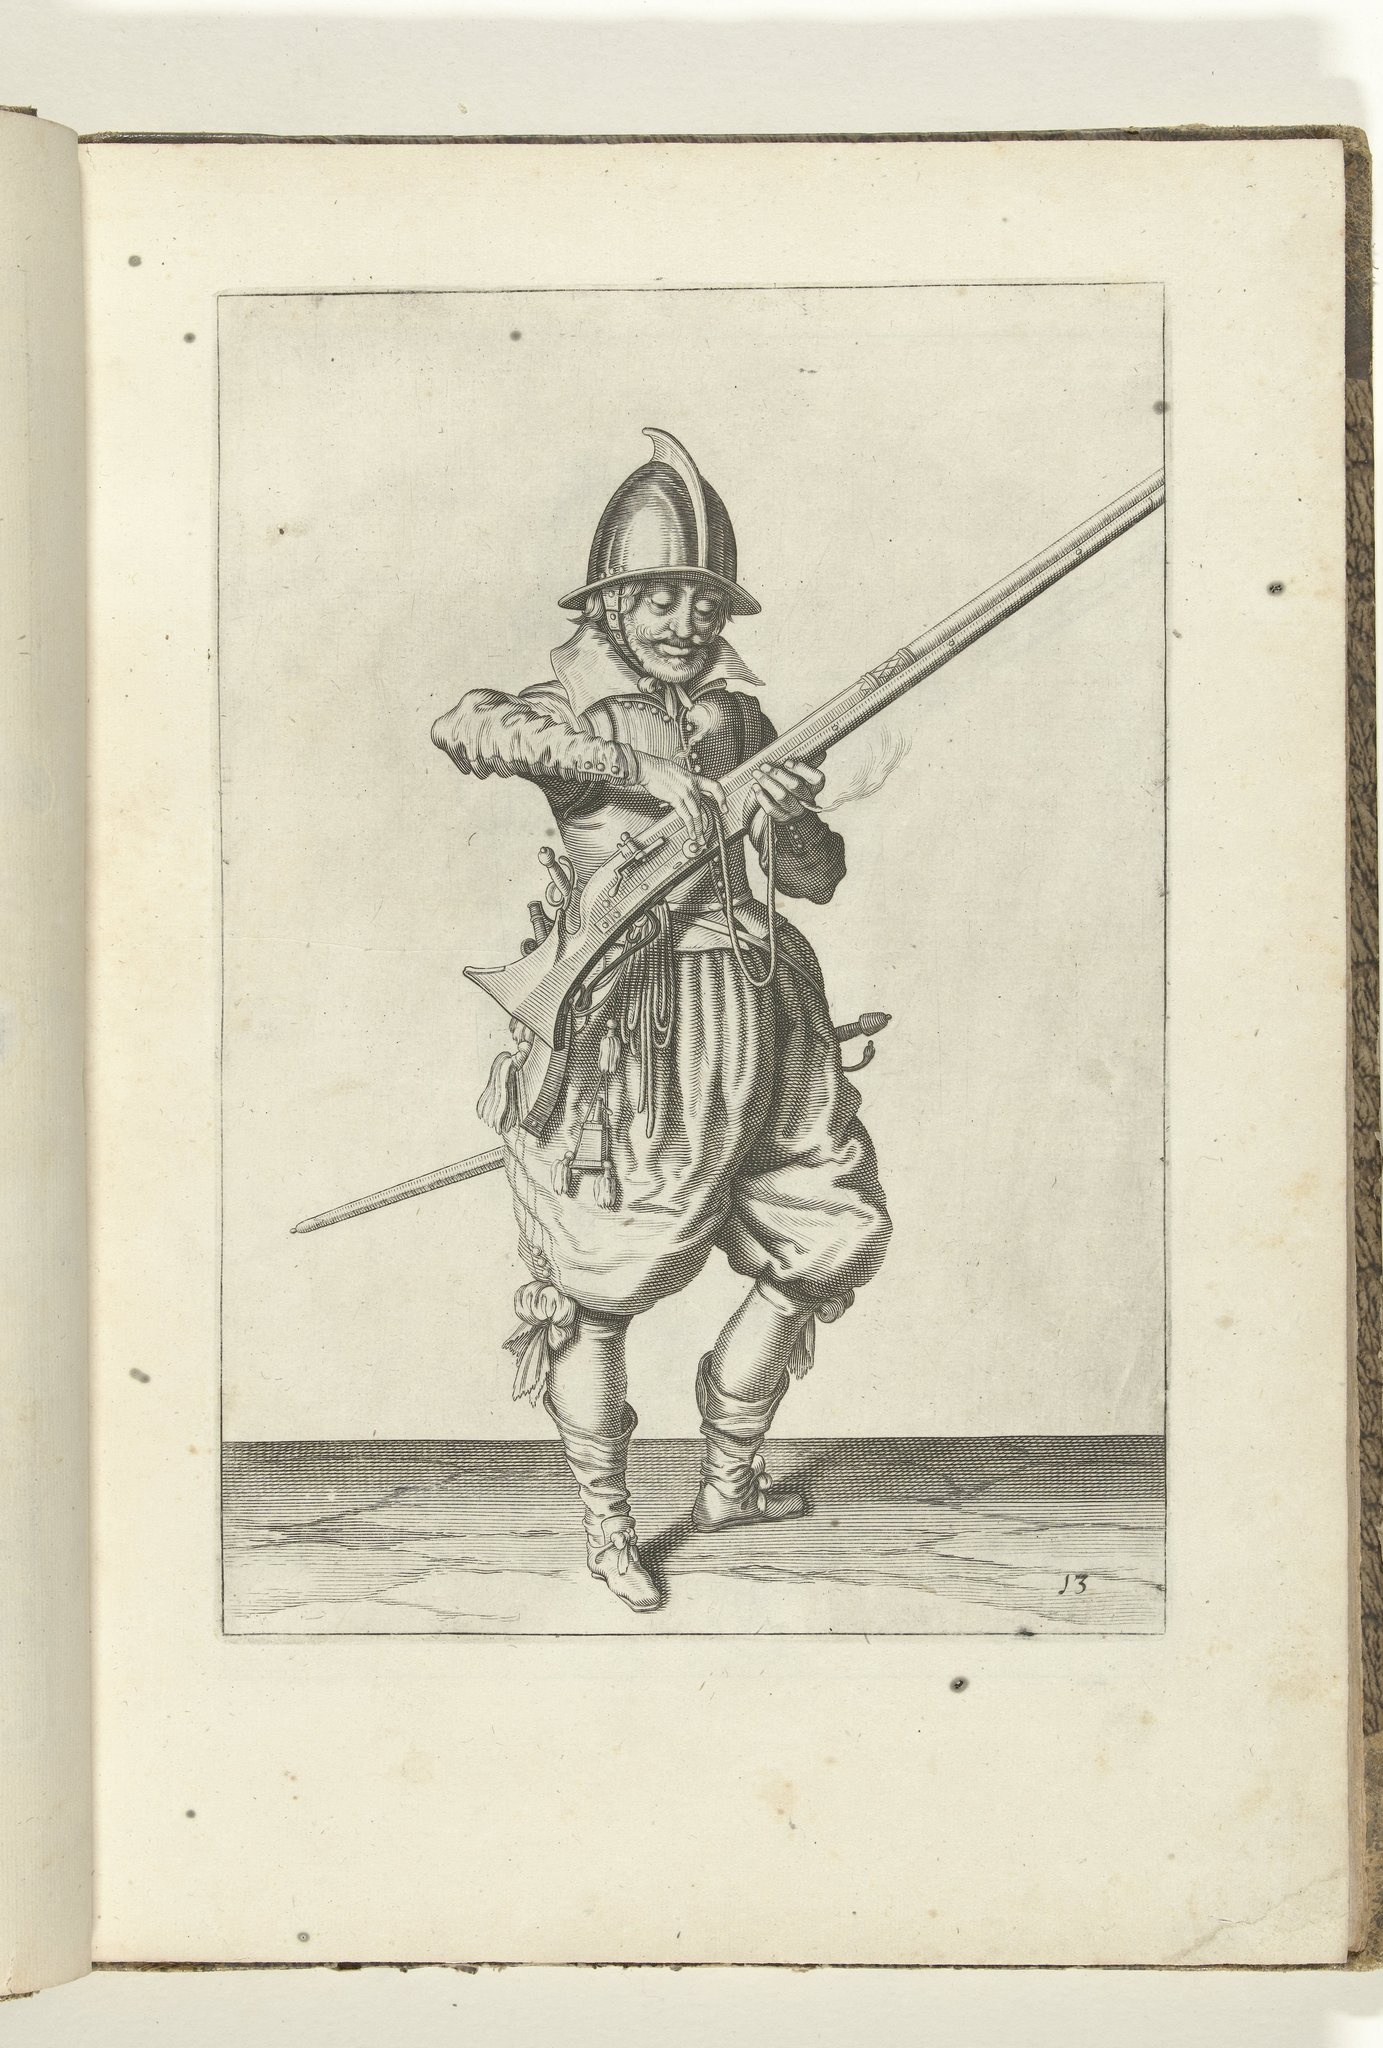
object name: print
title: Soldaat die zijn lont van de haan van zijn roer losmaakt (nr. 13), ca. 1600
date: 1597-1608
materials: paper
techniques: engraving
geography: northern netherlands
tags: the hague, maurice (prince of orange), handling of weapons ~ military training, weapons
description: Een soldaat, ten voeten uit, naar rechts, die een roer (een bepaald type vuurwapen) met zijn linkerhand vasthoudt (nr. 13), ca. 1600. Met zijn rechterhand maakt hij de brandende lont los die op de haan (onderdeel van het ontstekingsmechanisme) van zijn roer ligt. Plaat 13 in de instructies voor het hanteren van de roer: Brief enseignement, sur la representation des figures, du droit maniement de l'Harquebuse. Onderdeel van de illustraties in een Franse editie van J. de Gheyns Wapenhandelinghe: J. de Gheyn, Maniement d'armes, d'arquebuses, mousquetz et piques : en conformité de l'ordre de Mour le Prince Maurice, Prince d'Orange, Amsterdam 1608. Krijgswezen rond 1600.